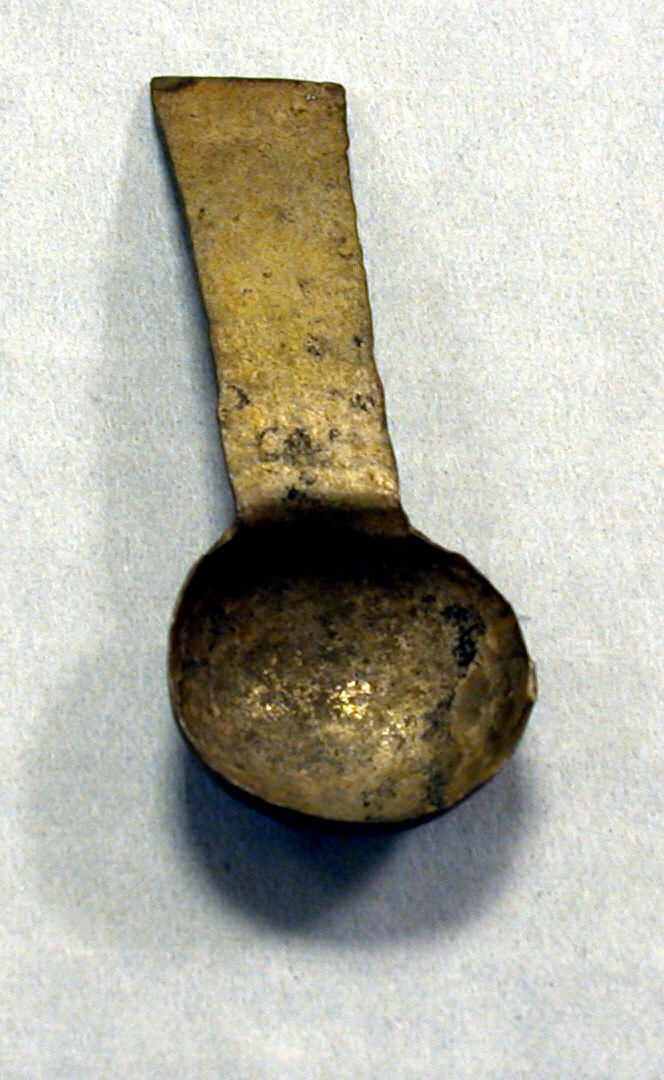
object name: spoon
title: Hammered Silver Spoon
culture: peruvian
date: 701-1566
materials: gilt, silver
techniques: hammering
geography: peru